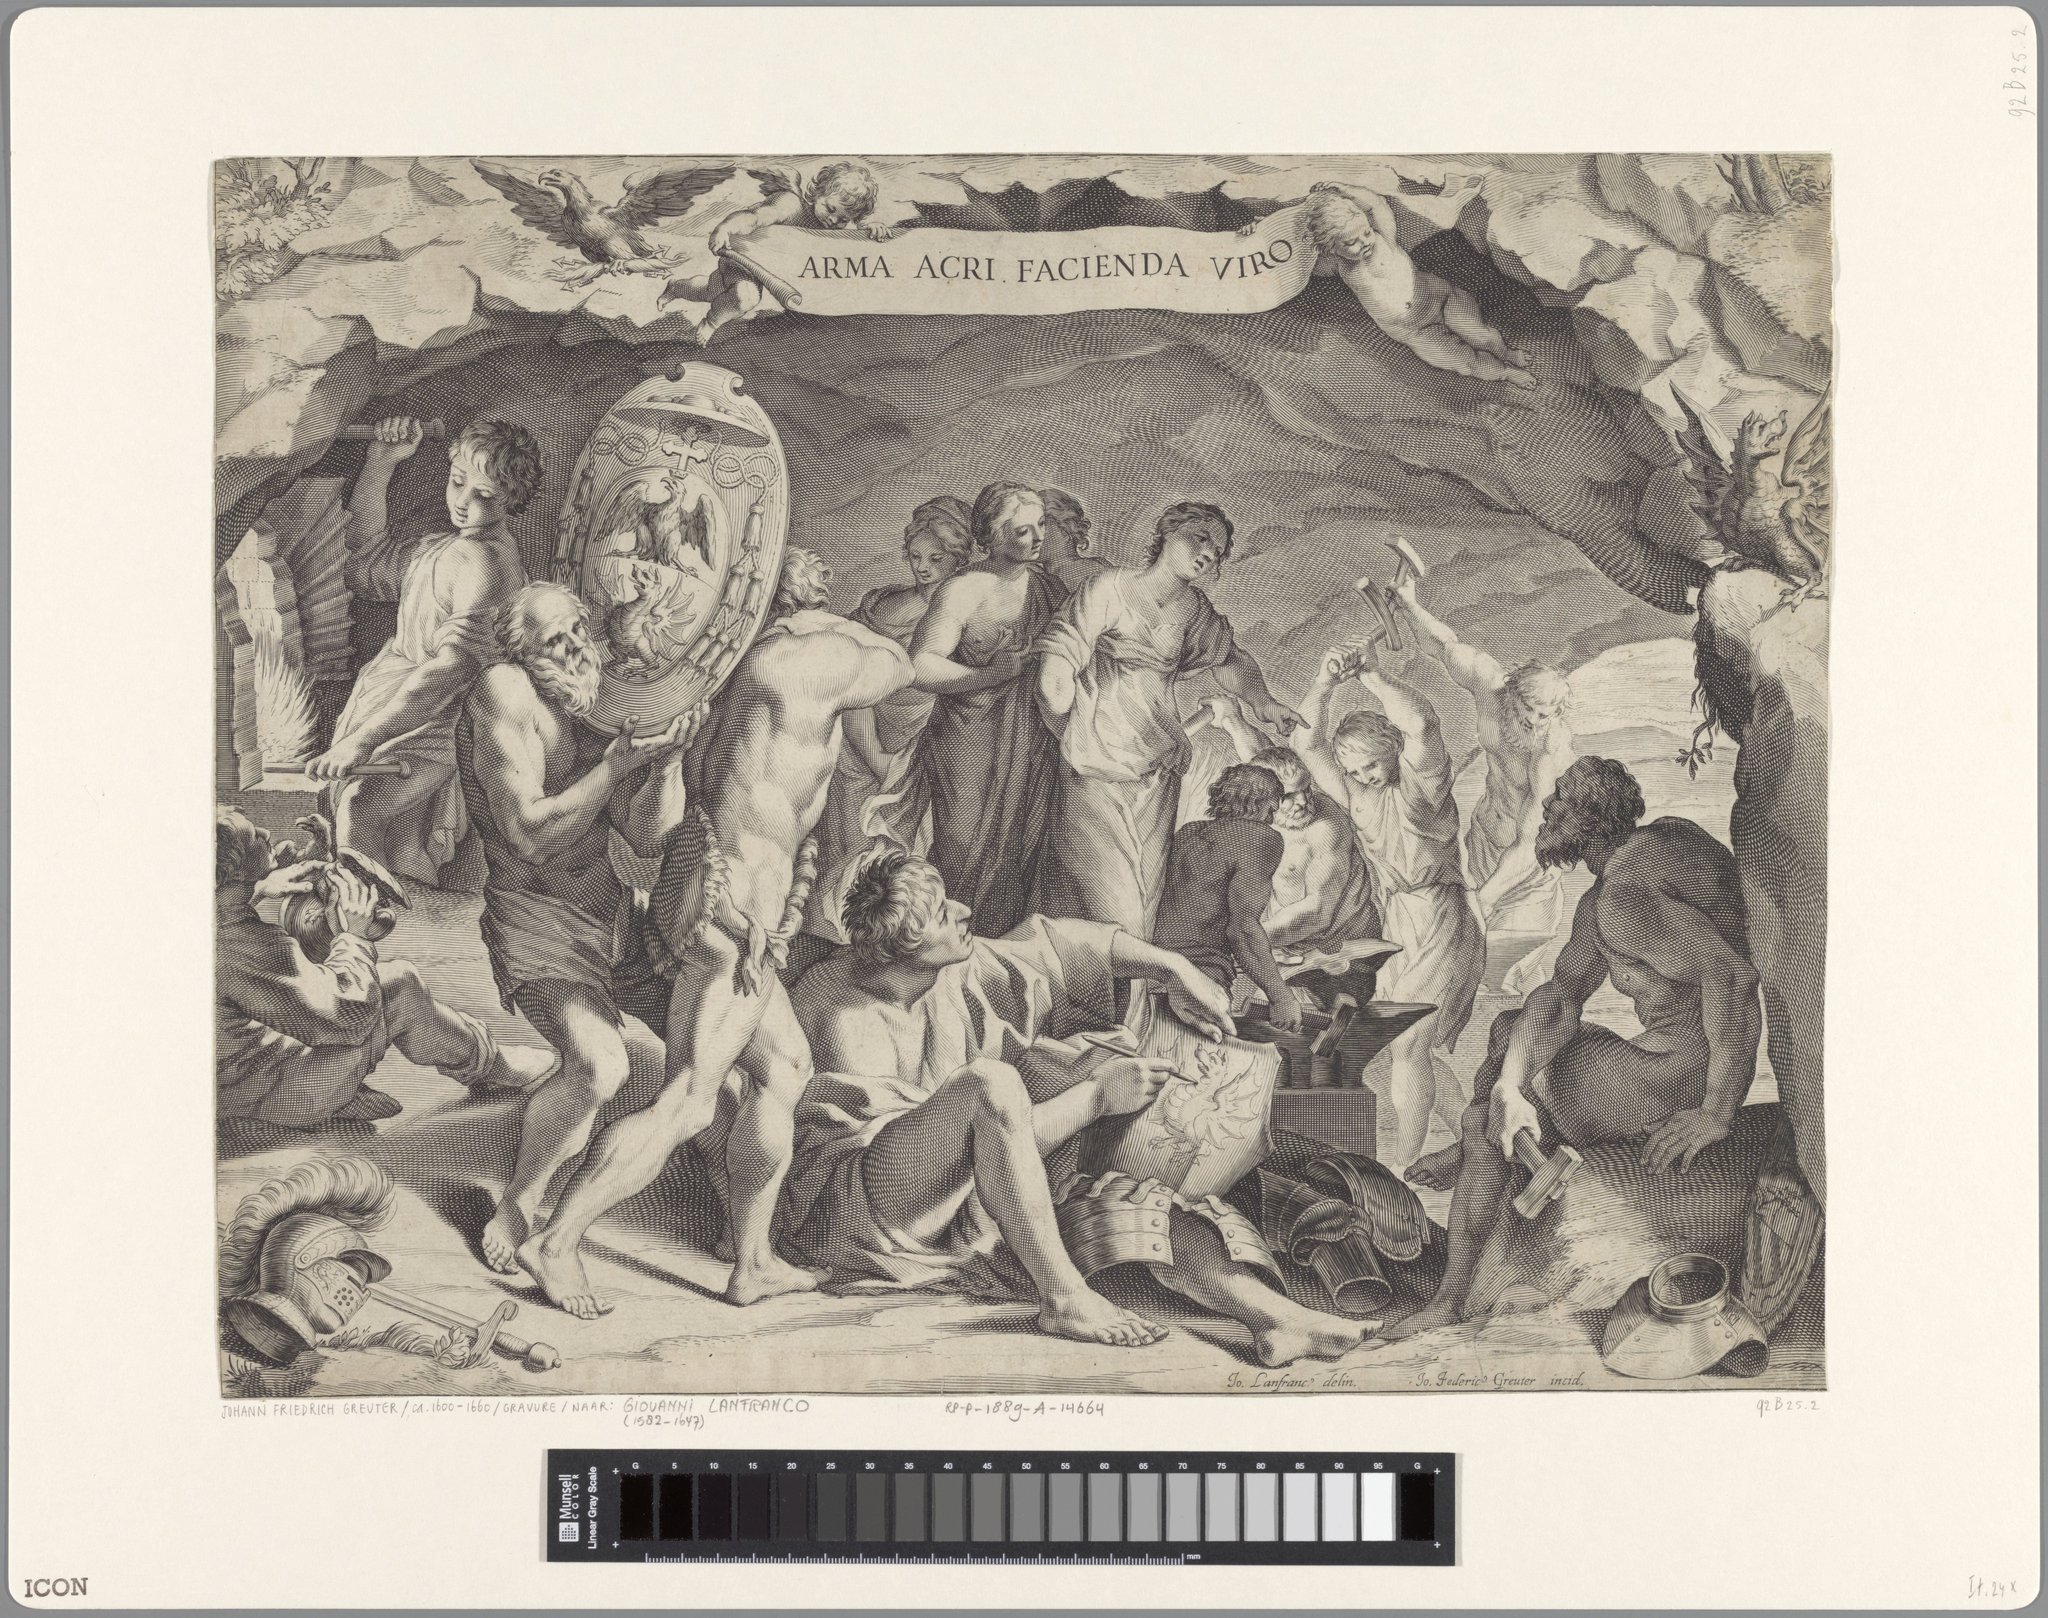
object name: print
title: De smidse van Vulcanus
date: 1599-1662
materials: paper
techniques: engraving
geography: italy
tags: vulcan in his smithy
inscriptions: collector's mark: Lugt 2228, collector's mark: Lugt 789a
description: Een groep mannen aan het werk in de smidse van Vulcanus. Op de achtergrond een groep vrouwen. Middenboven een banderol met de tekst: Arma acri facienda viro.